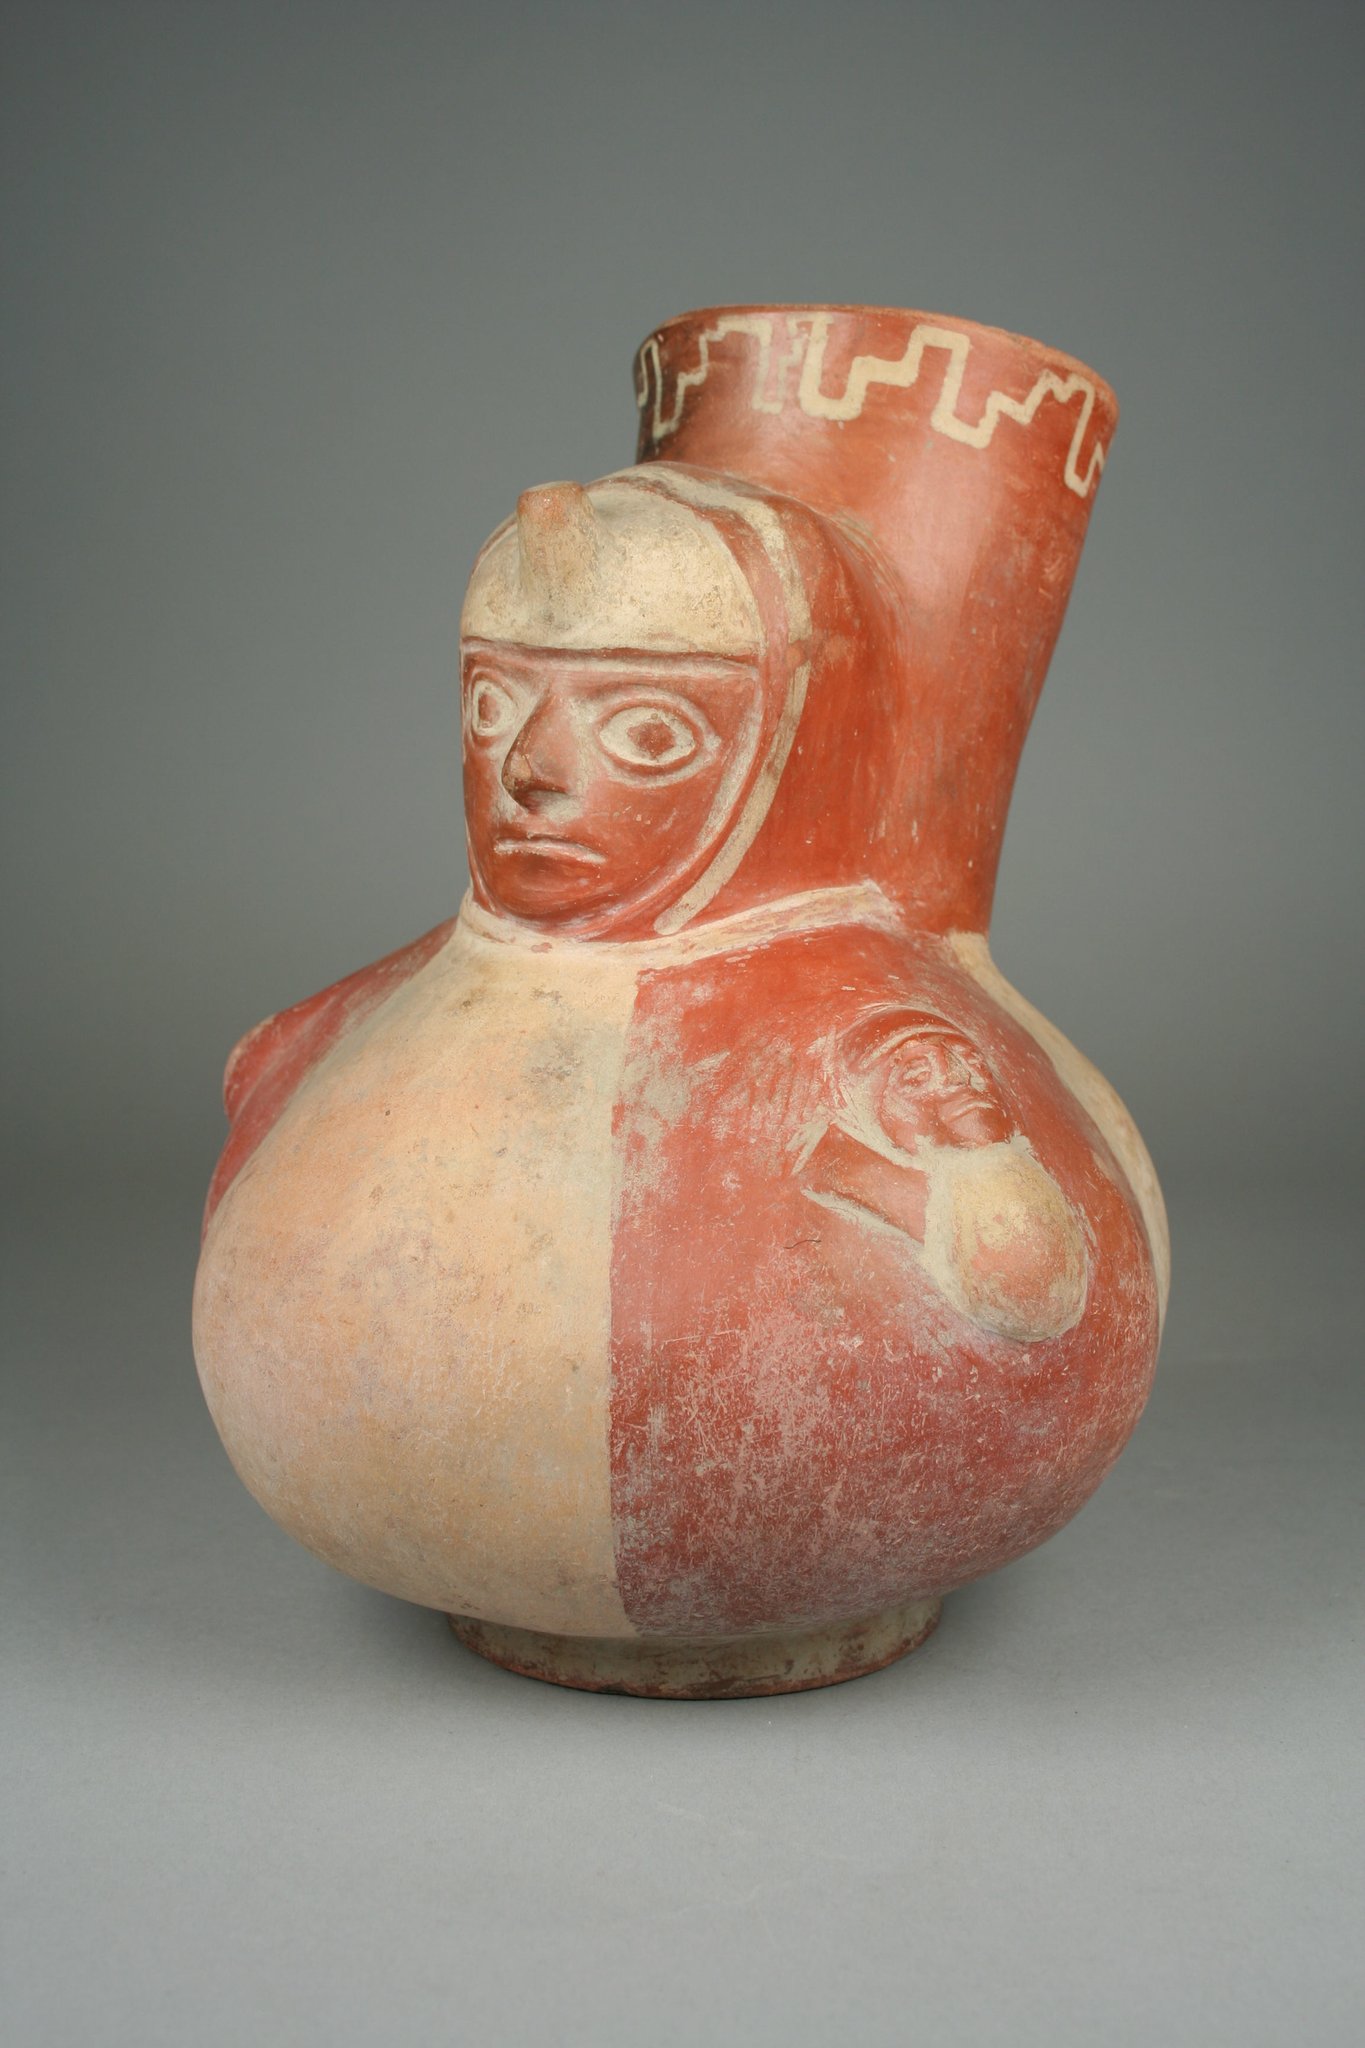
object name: bottle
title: Single Spout Bottle with Gadrooned Figure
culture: moche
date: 201-700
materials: ceramic, pigment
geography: peru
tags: faces